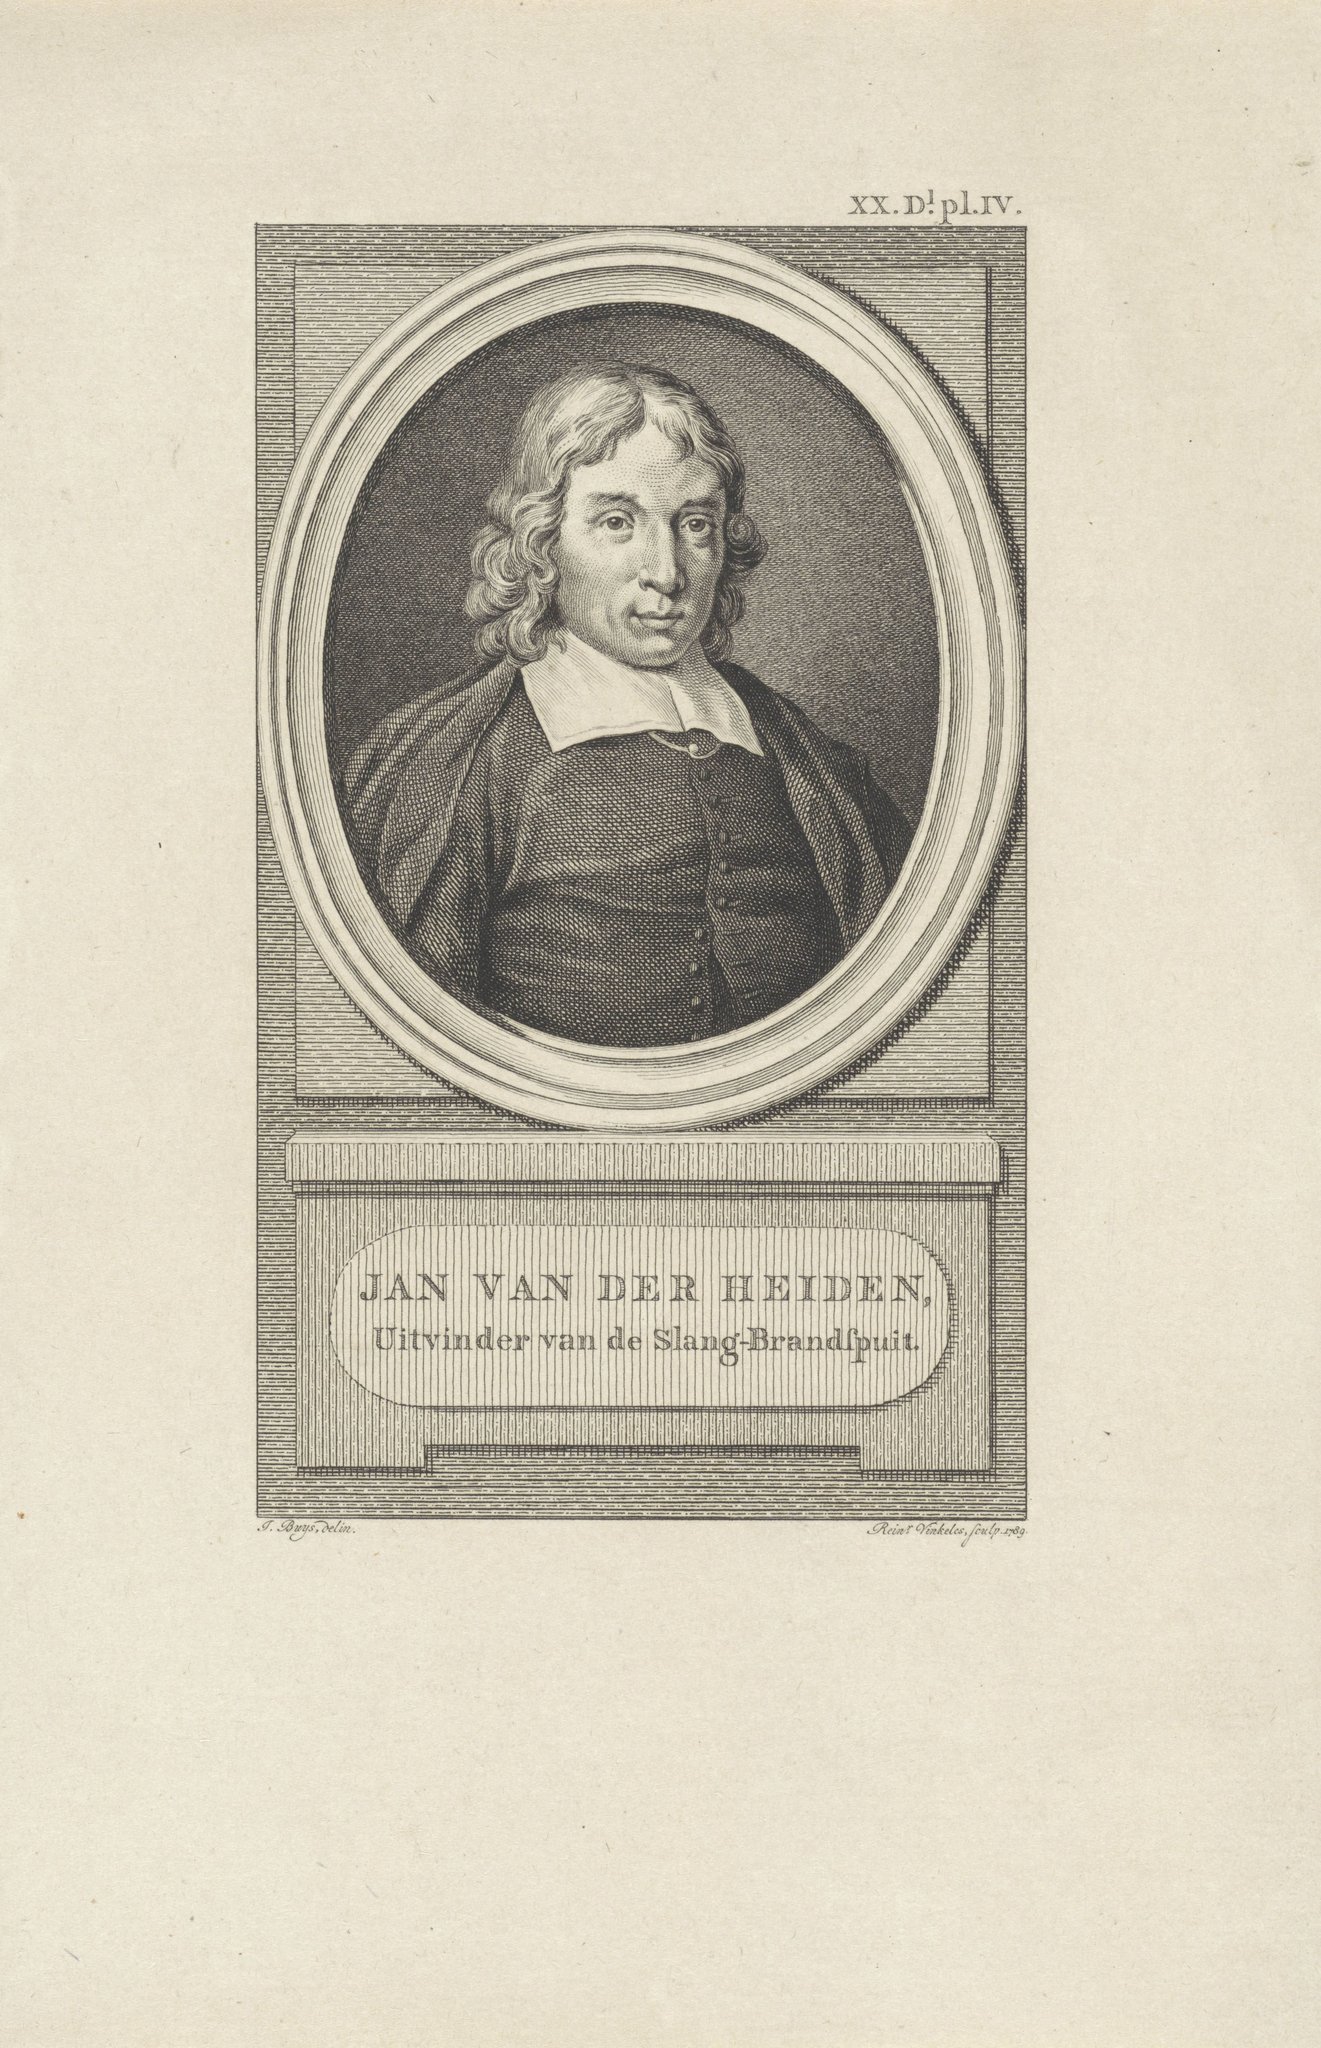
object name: book illustration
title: Portret van Jan van der Heyden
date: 1789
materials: paper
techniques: engraving, etching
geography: amsterdam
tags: amsterdam, painter, print maker, draughtsman, jan van der heyden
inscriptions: collector's mark: Lugt 2228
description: Prent gebruikt als boekillustratie in: Kok, Jacobus. Vaderlandsch woordenboek : met kaarten, plaaten en pourtraitten. Amsterdam: Johannes Allart, 1785-1796. Deel XX.